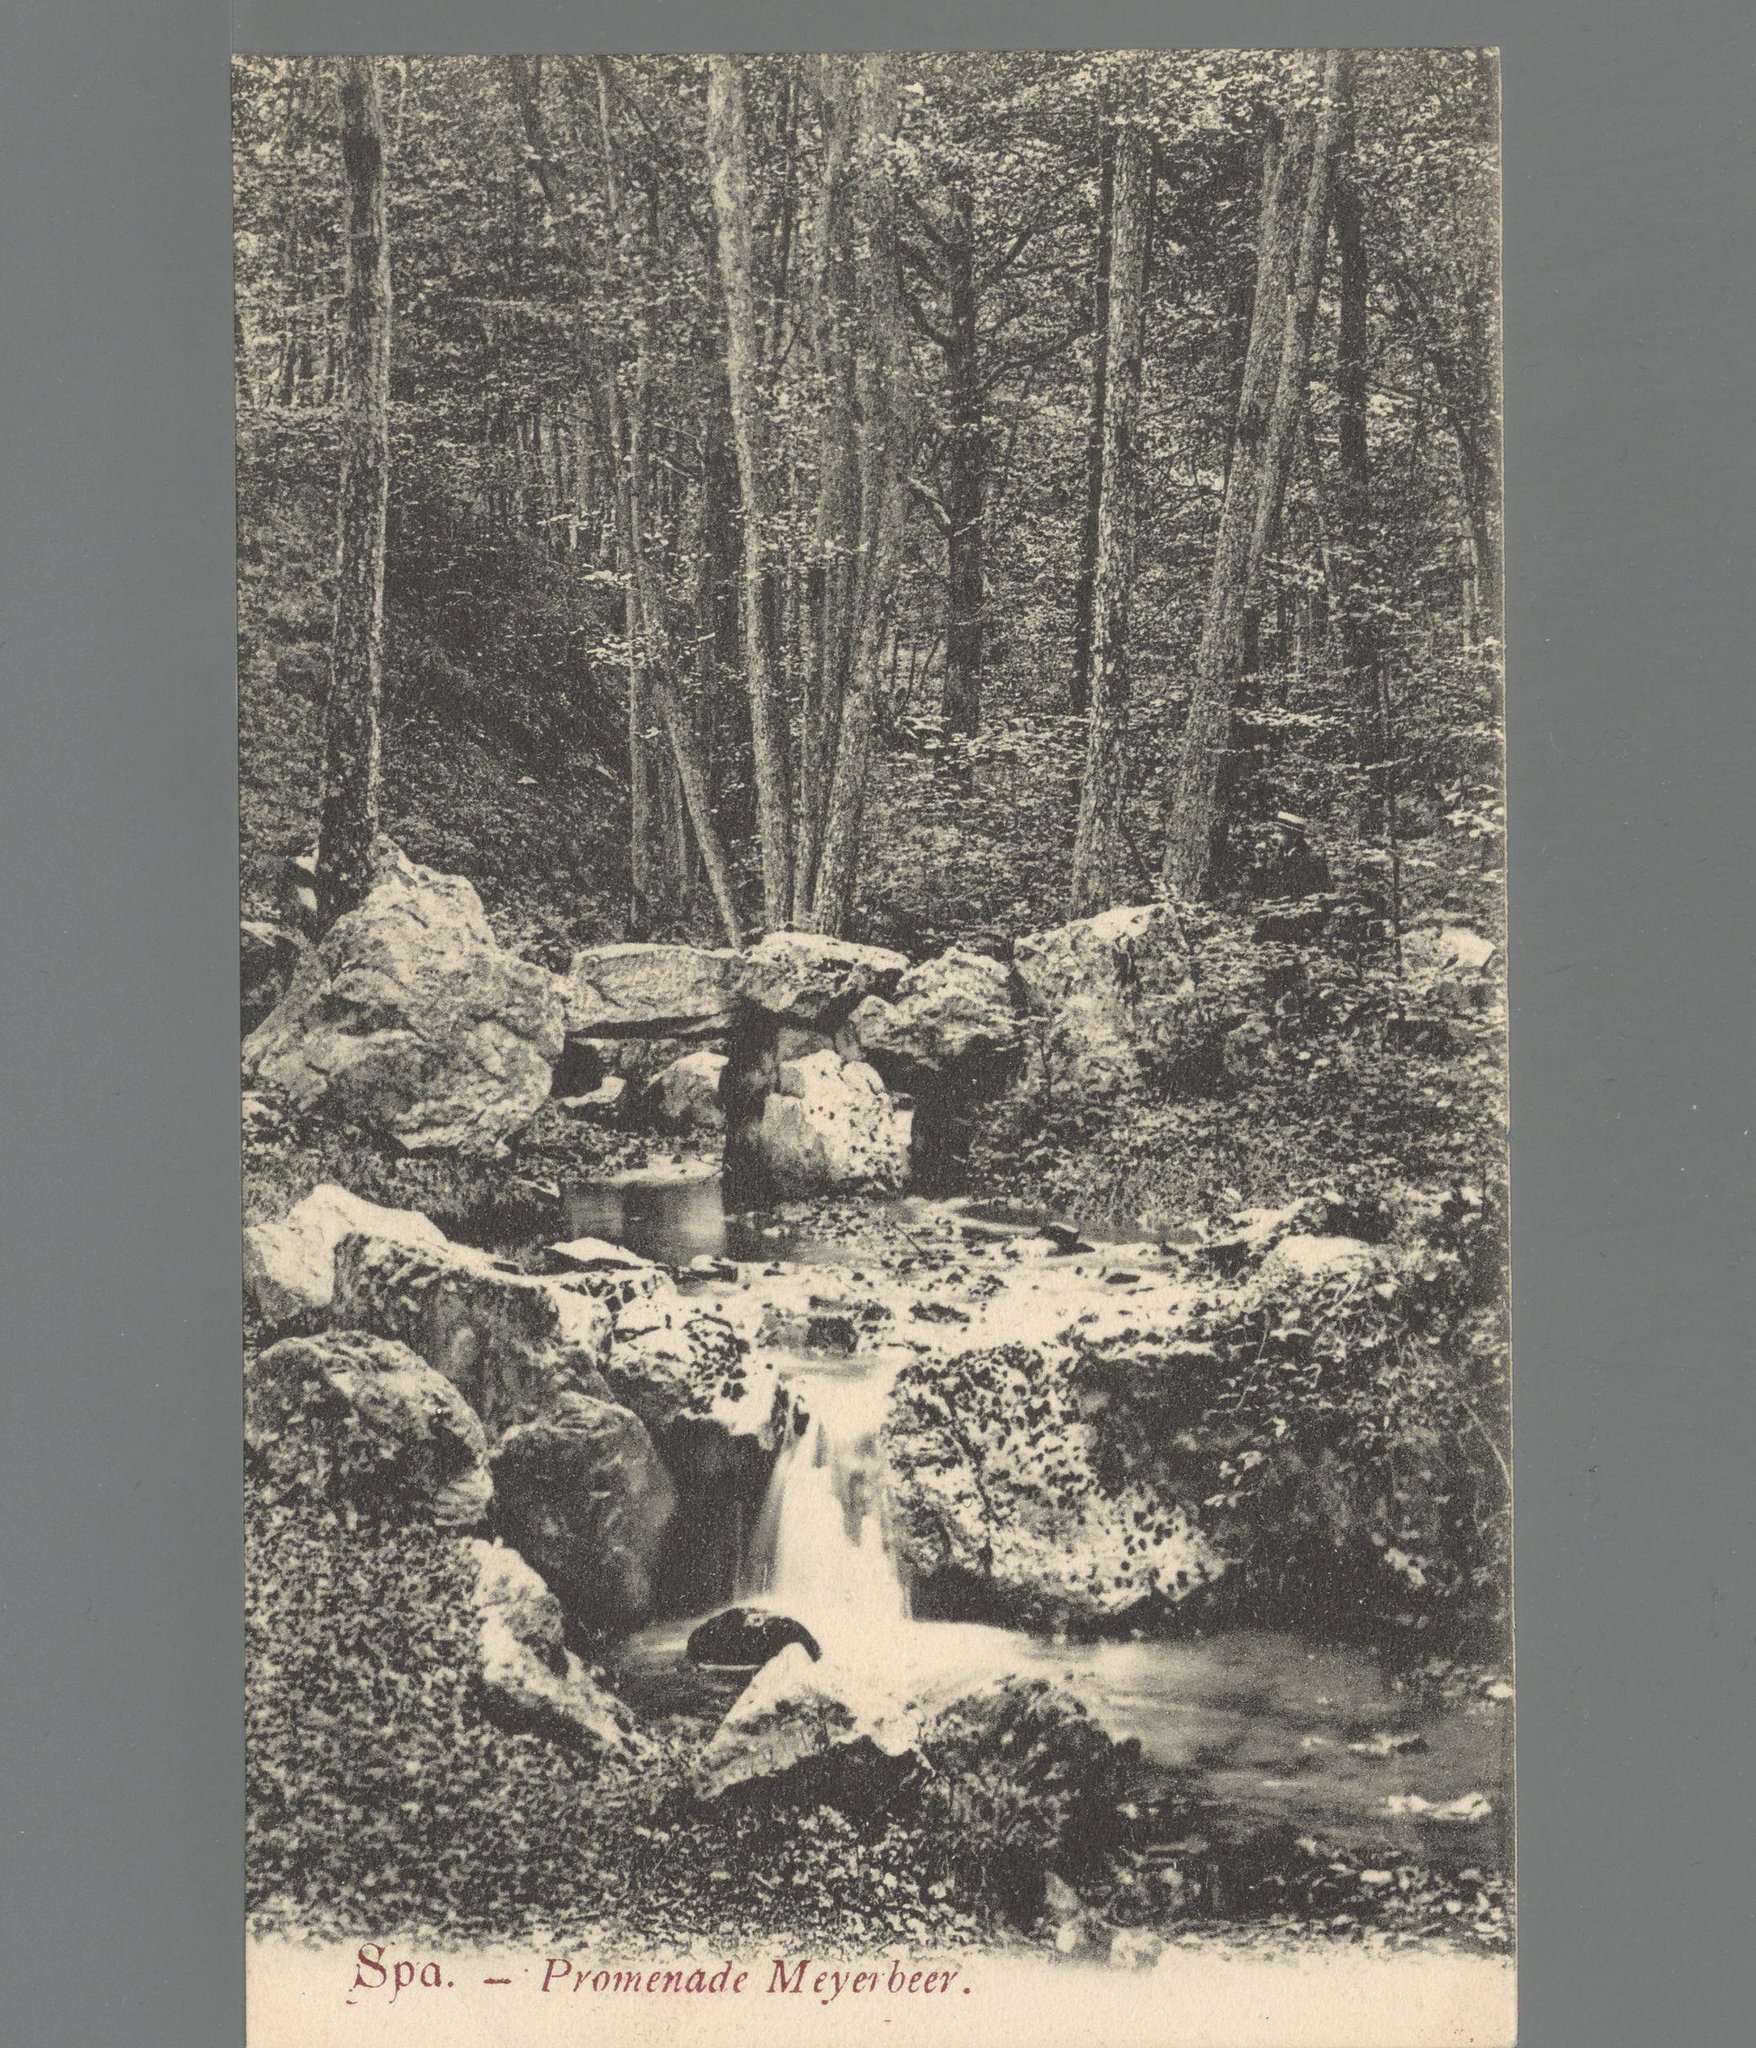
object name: photomechanical print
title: Spa. Promenade Meyerbeer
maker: Anonymous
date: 1892-1906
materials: cardboard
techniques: photograph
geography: spa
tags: forest, wood